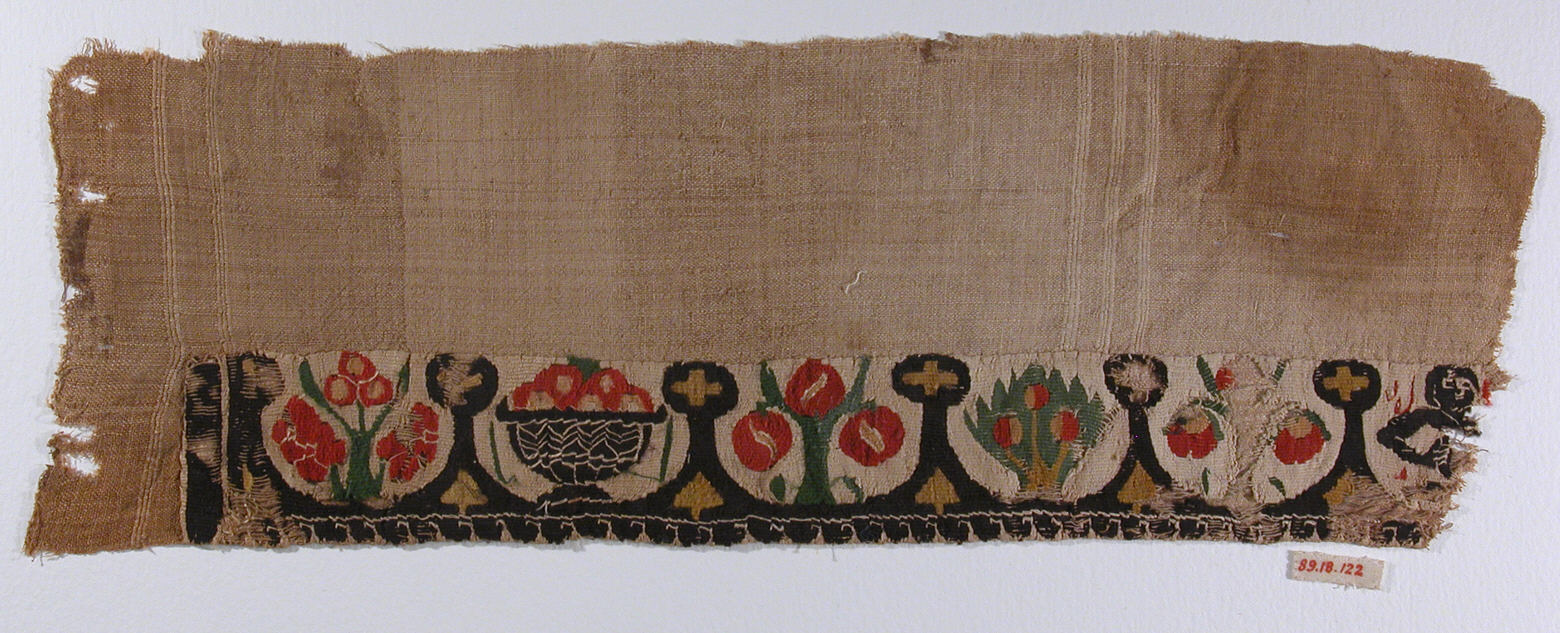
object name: textile fragment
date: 301-700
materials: linen, wool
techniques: weave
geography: egypt